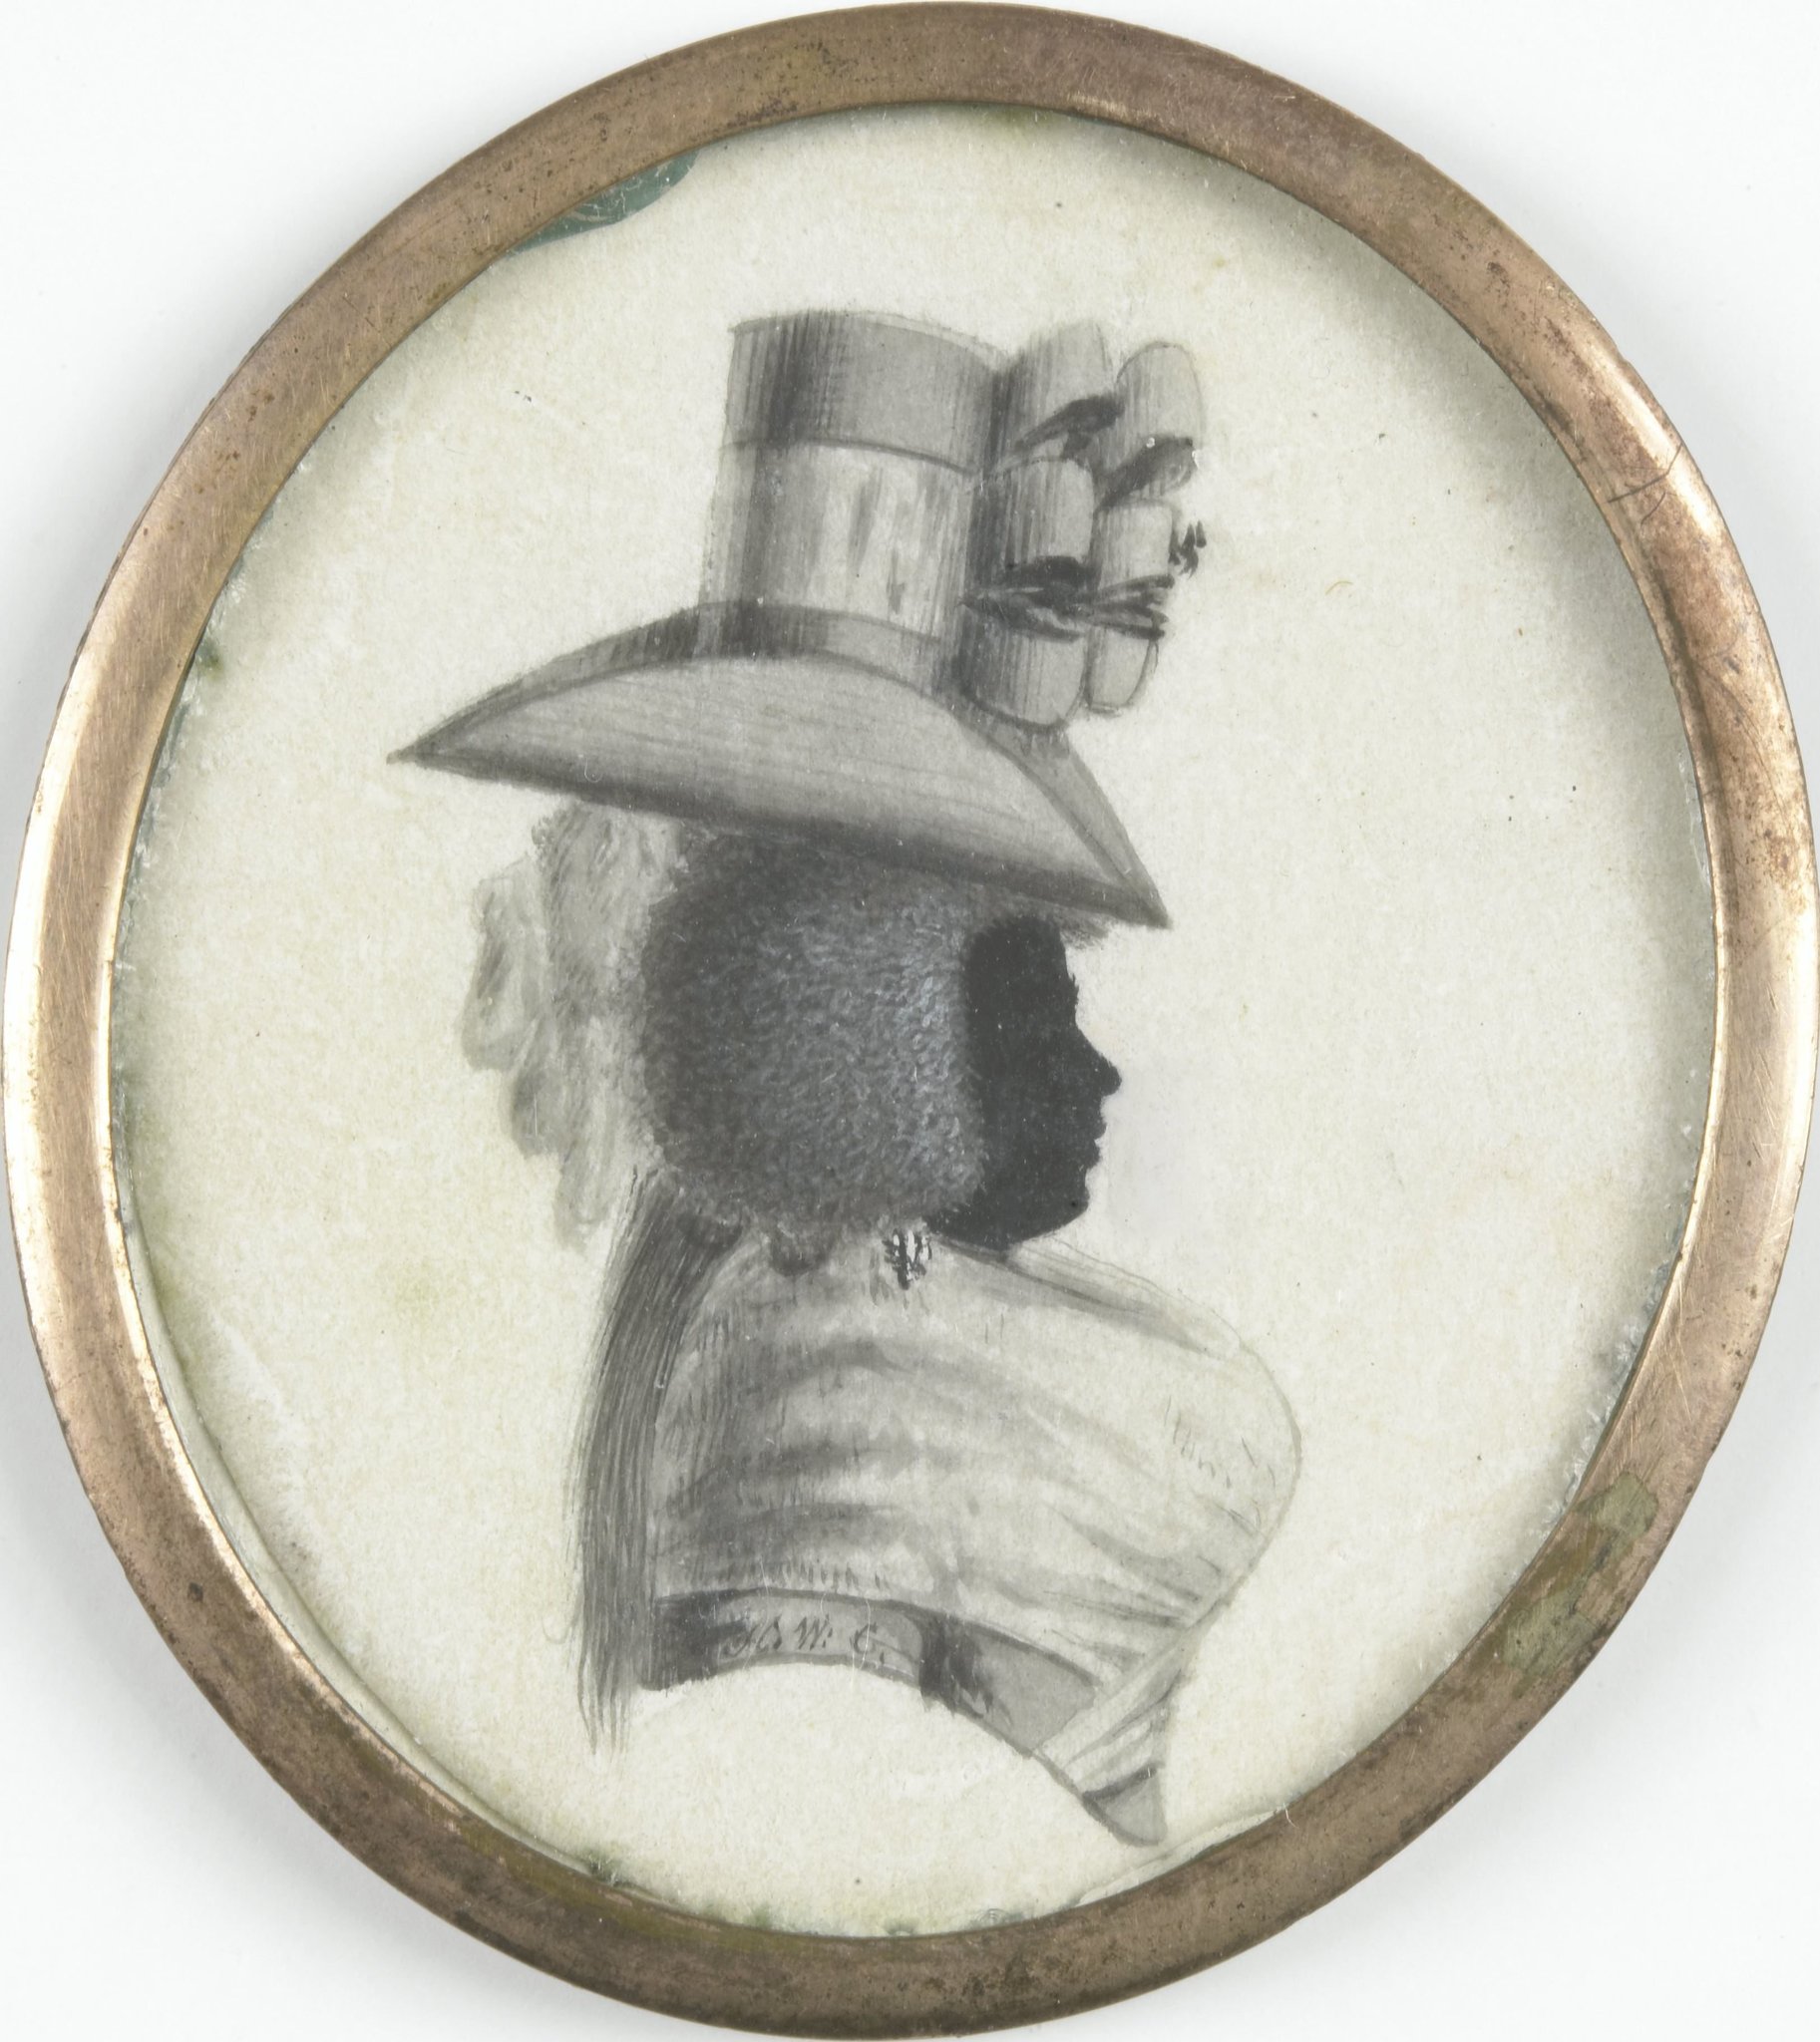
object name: painting, miniature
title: Portret van een vrouw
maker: Anonymous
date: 1790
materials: glass, metal, parchment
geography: northern netherlands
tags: historical persons not known by name - bb - woman, suriname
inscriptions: signature: ‘HWC [of HVWC]’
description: Silhouet portret van een Surinaamse vrouw. Buste, naar rechts. Met prominente boezem en hoge hoed met strikken. Onderdeel van de collectie portretminiaturen.